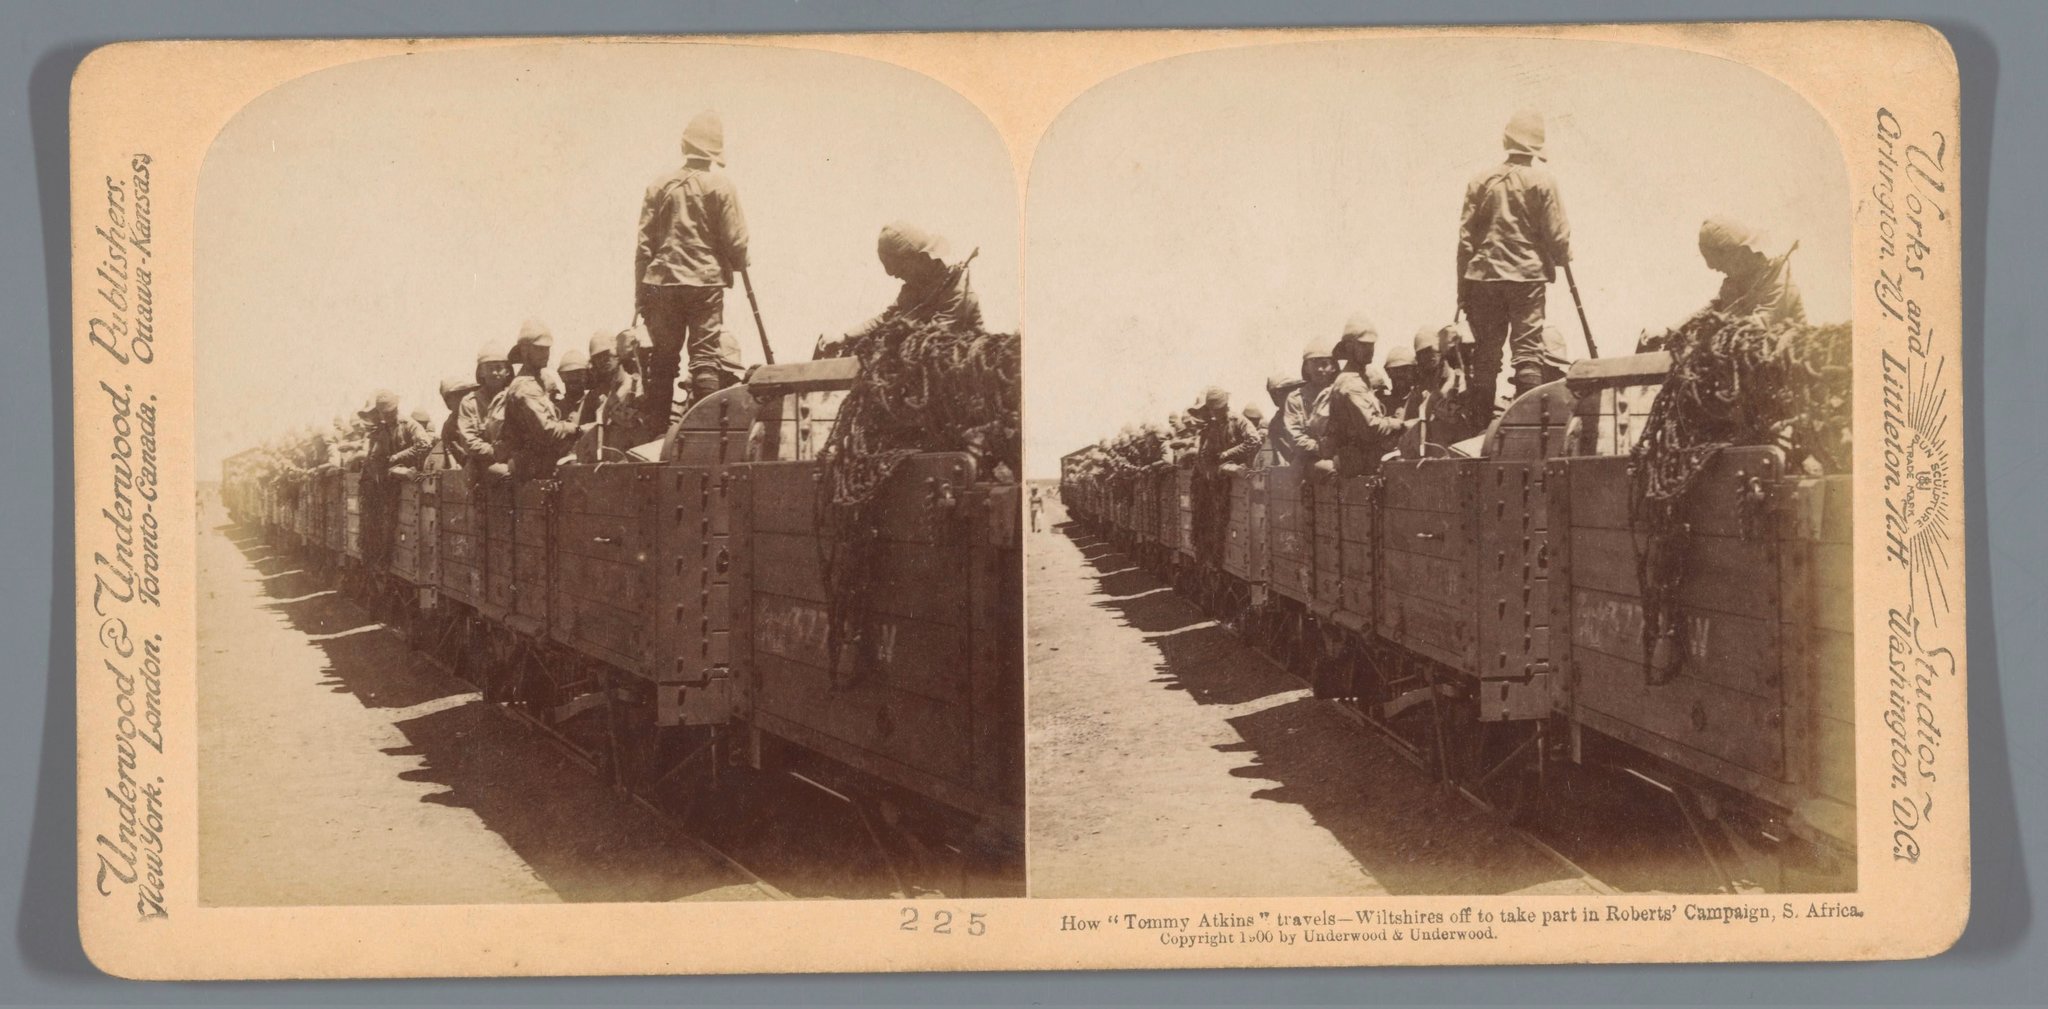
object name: stereograph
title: How "Tommy Atkins" travels - Wiltshires off to take part in Roberts' Campaign, S. Africa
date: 1900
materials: cardboard, photographic support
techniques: albumen print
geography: south africa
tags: the soldier; the soldier's life, transport, train (military)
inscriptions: number: ‘225’, name: ‘Works and Studios Sun Sculpture trade mark Arlington N.J. Littleton N.H. Washington D.C.’